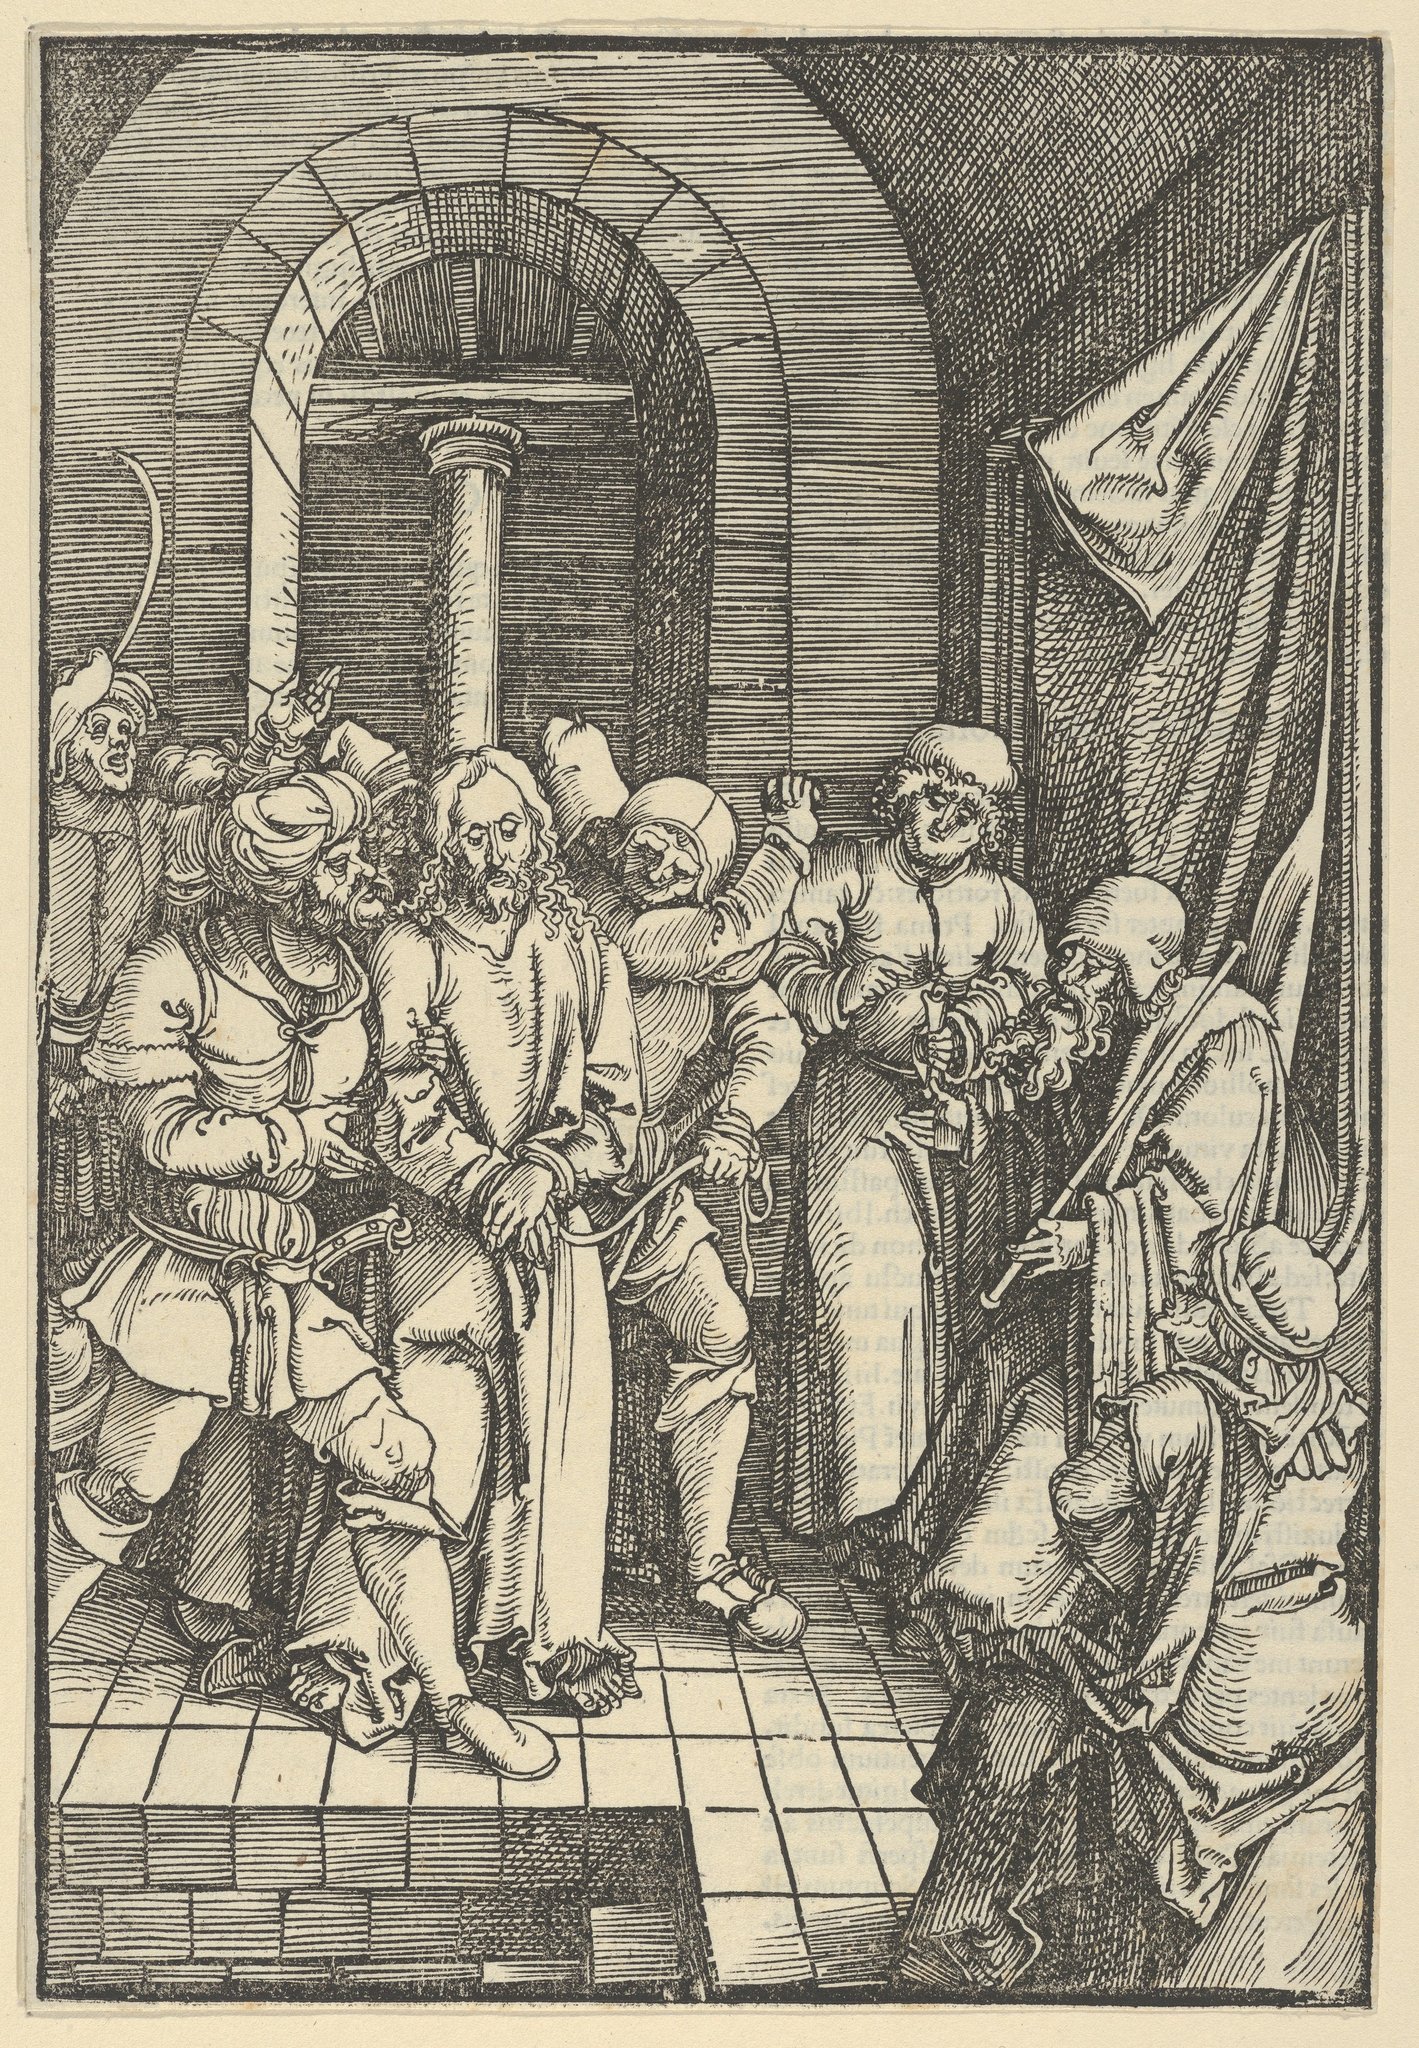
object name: print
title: Christ before Annas, from Speculum passionis domini nostri Ihesu Christi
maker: hans schäufelein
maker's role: artist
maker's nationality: german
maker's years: 1480-1540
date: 1507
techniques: woodcut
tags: men,christ